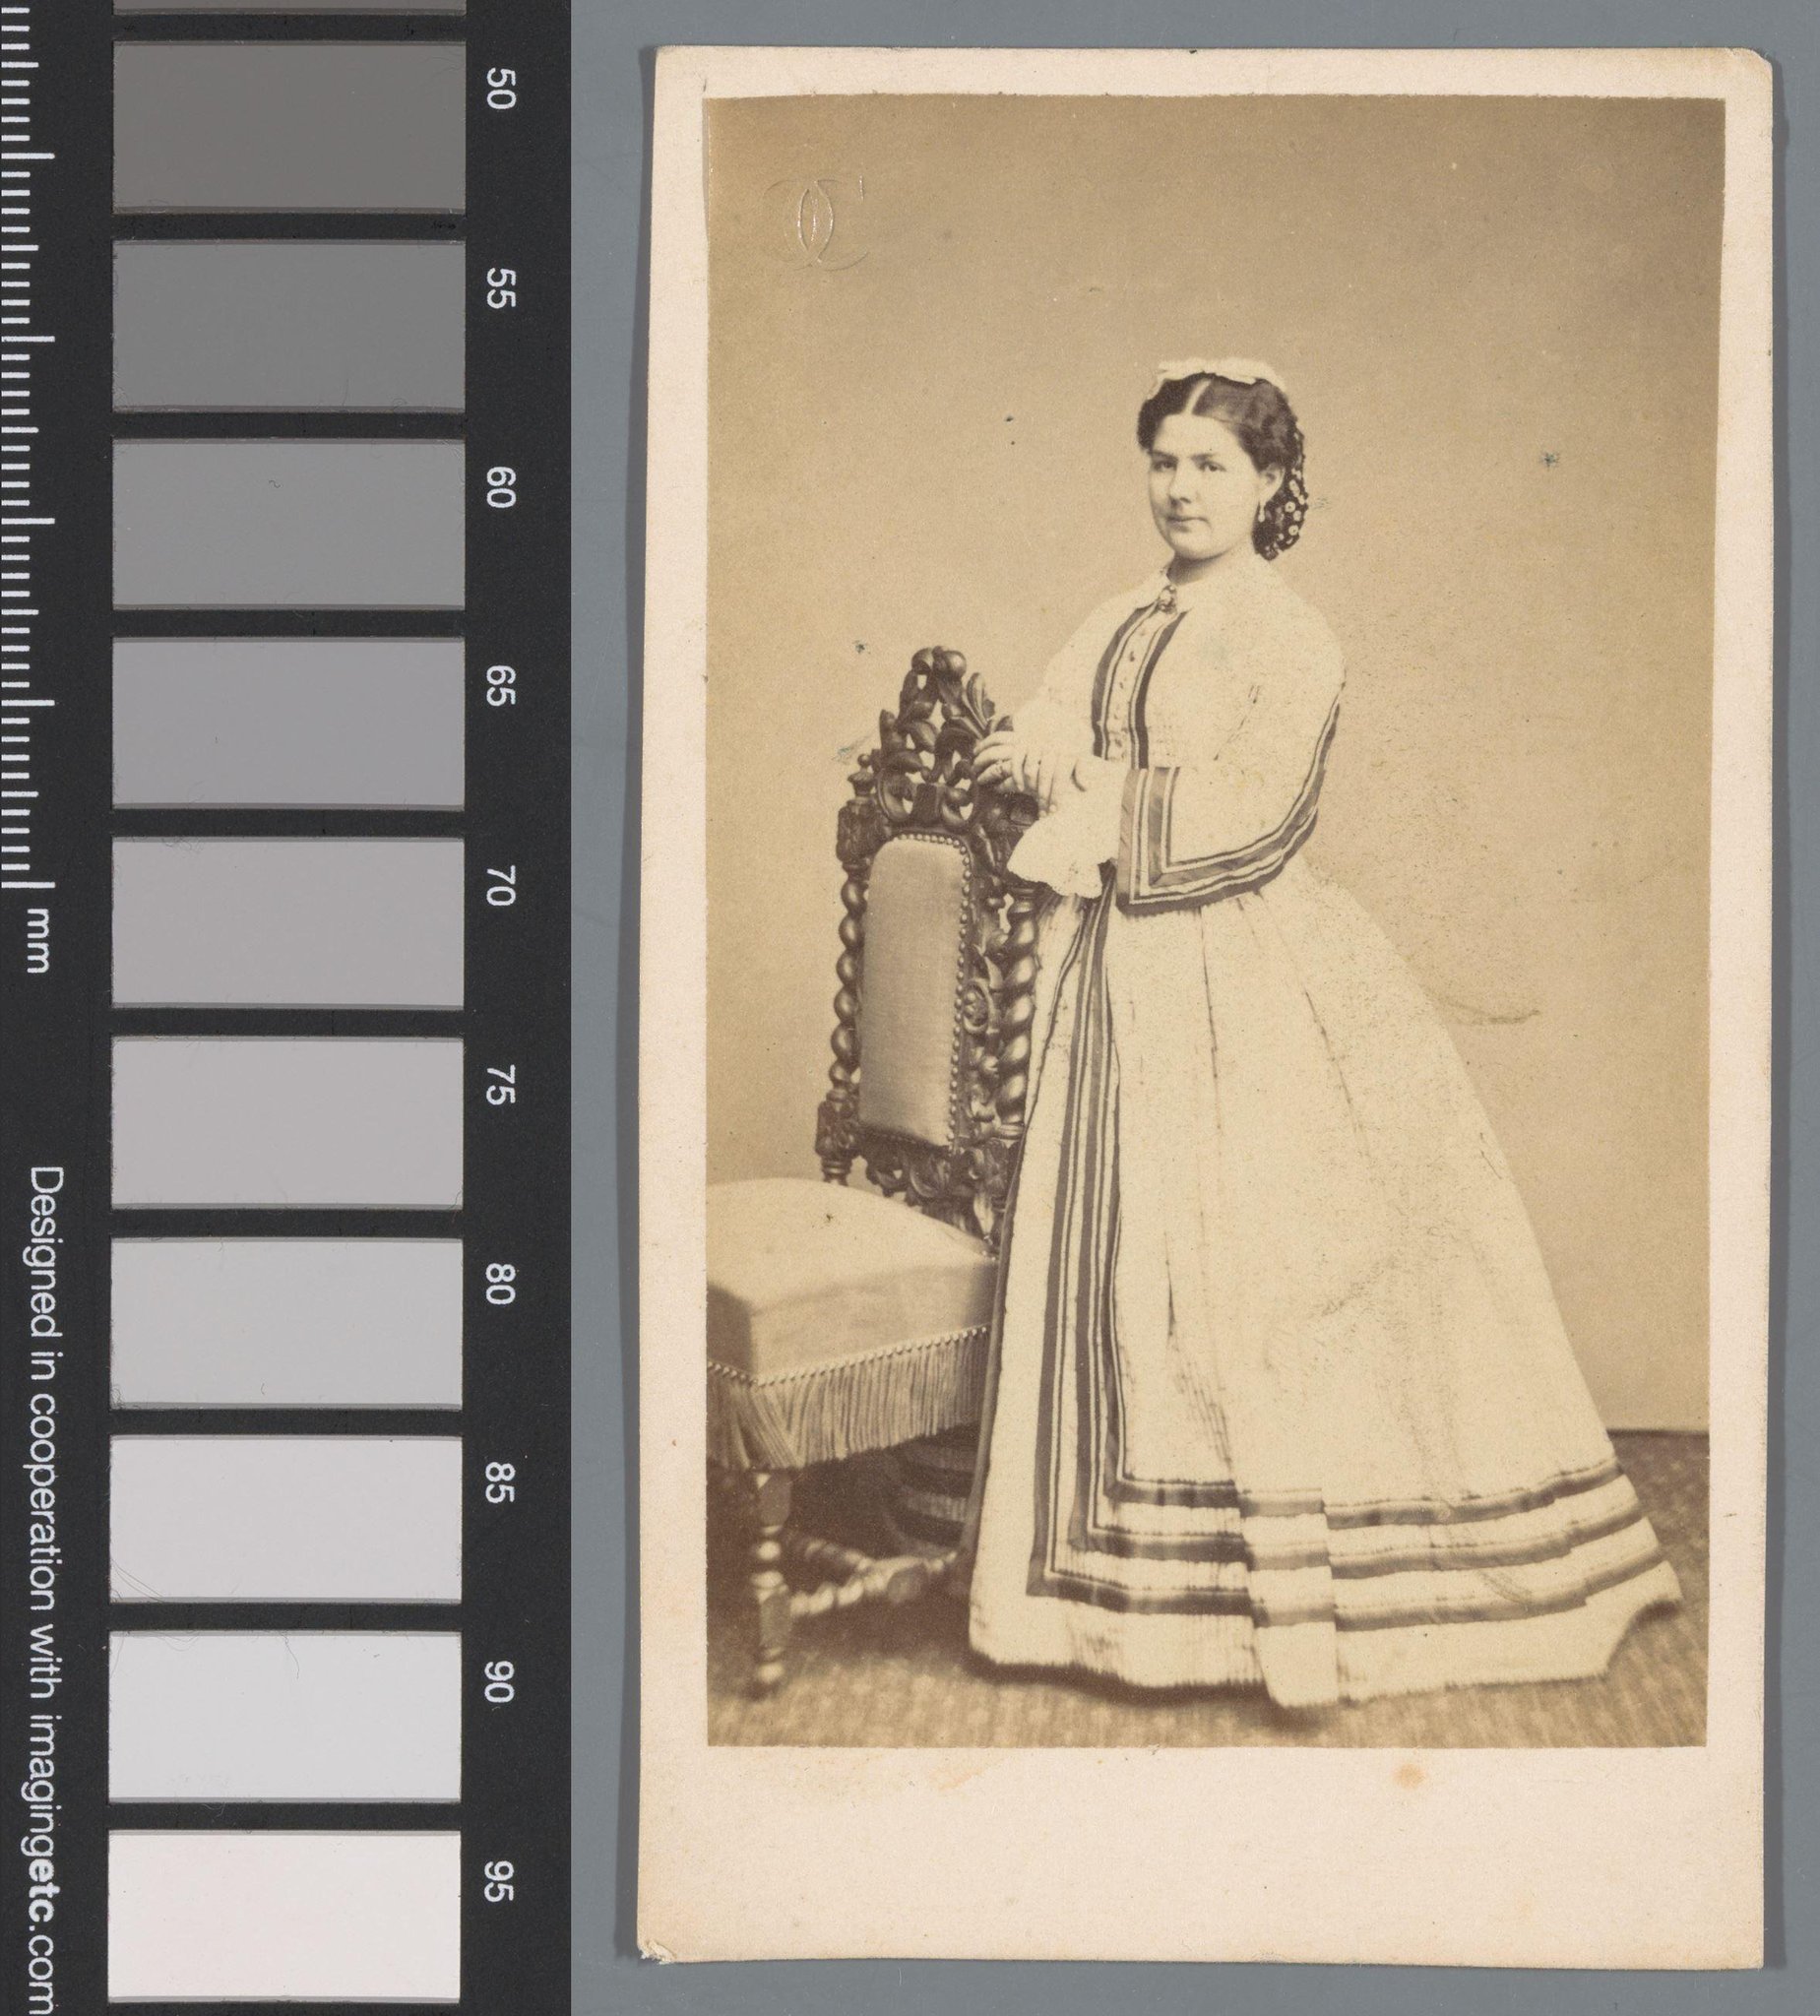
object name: photograph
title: Portret van een onbekende vrouw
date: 1855-1885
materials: cardboard, paper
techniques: albumen print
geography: paris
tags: adult woman, anonymous historical person portrayed, paris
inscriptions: monogram: ‘CC’, inscription: ‘Photographie/ Ane Mon Constantin/ 11, Rue Chauchat,/ Derrière l'Opera./ Paris’